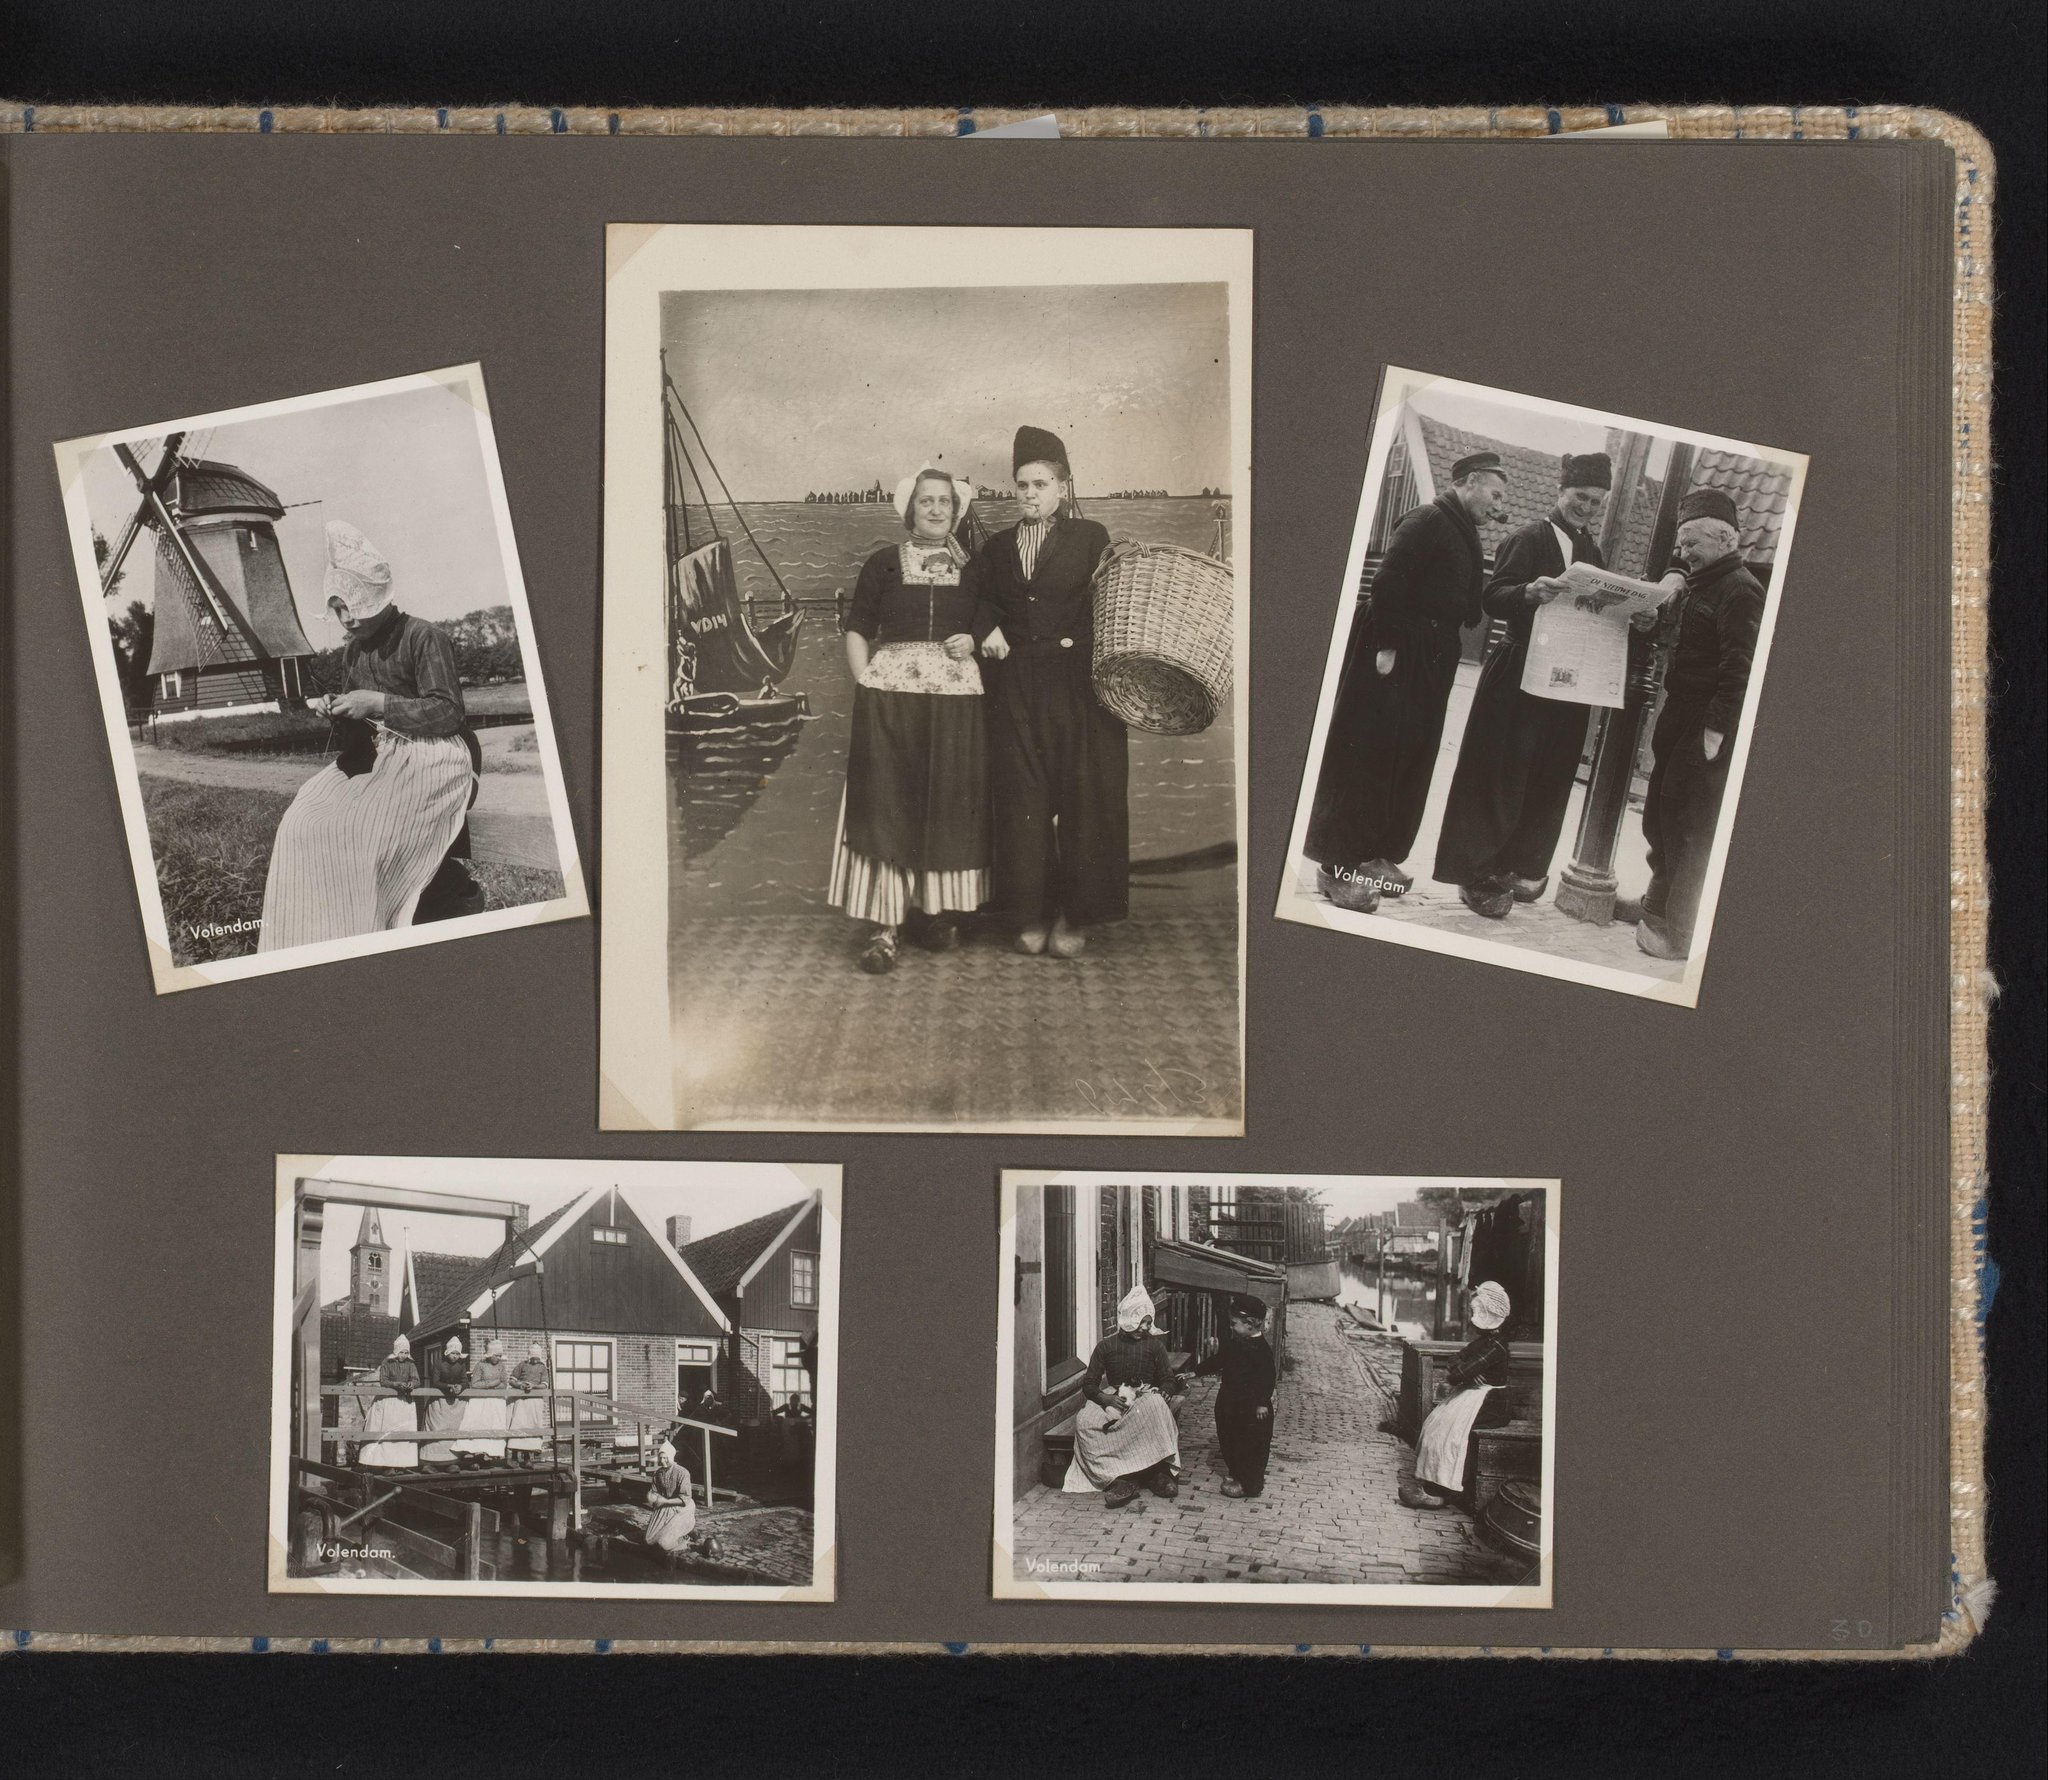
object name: album leaf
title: Volendam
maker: Anonymous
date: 1935-1942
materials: cardboard, photographic support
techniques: gelatin silver print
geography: volendam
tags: folk costume, regional costume, the soldier off duty, occupation ~ war, netherlands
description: Albumblad met vijf foto's te Volendam, waarvan vier gekochte foto's en de vijfde van de echtgenote en dochter poserend in Volendammer klederdracht in een fotostudio. Onderdeel van het fotoalbum Abrechnungsintendantur van de Wehrmacht 1941-1943.